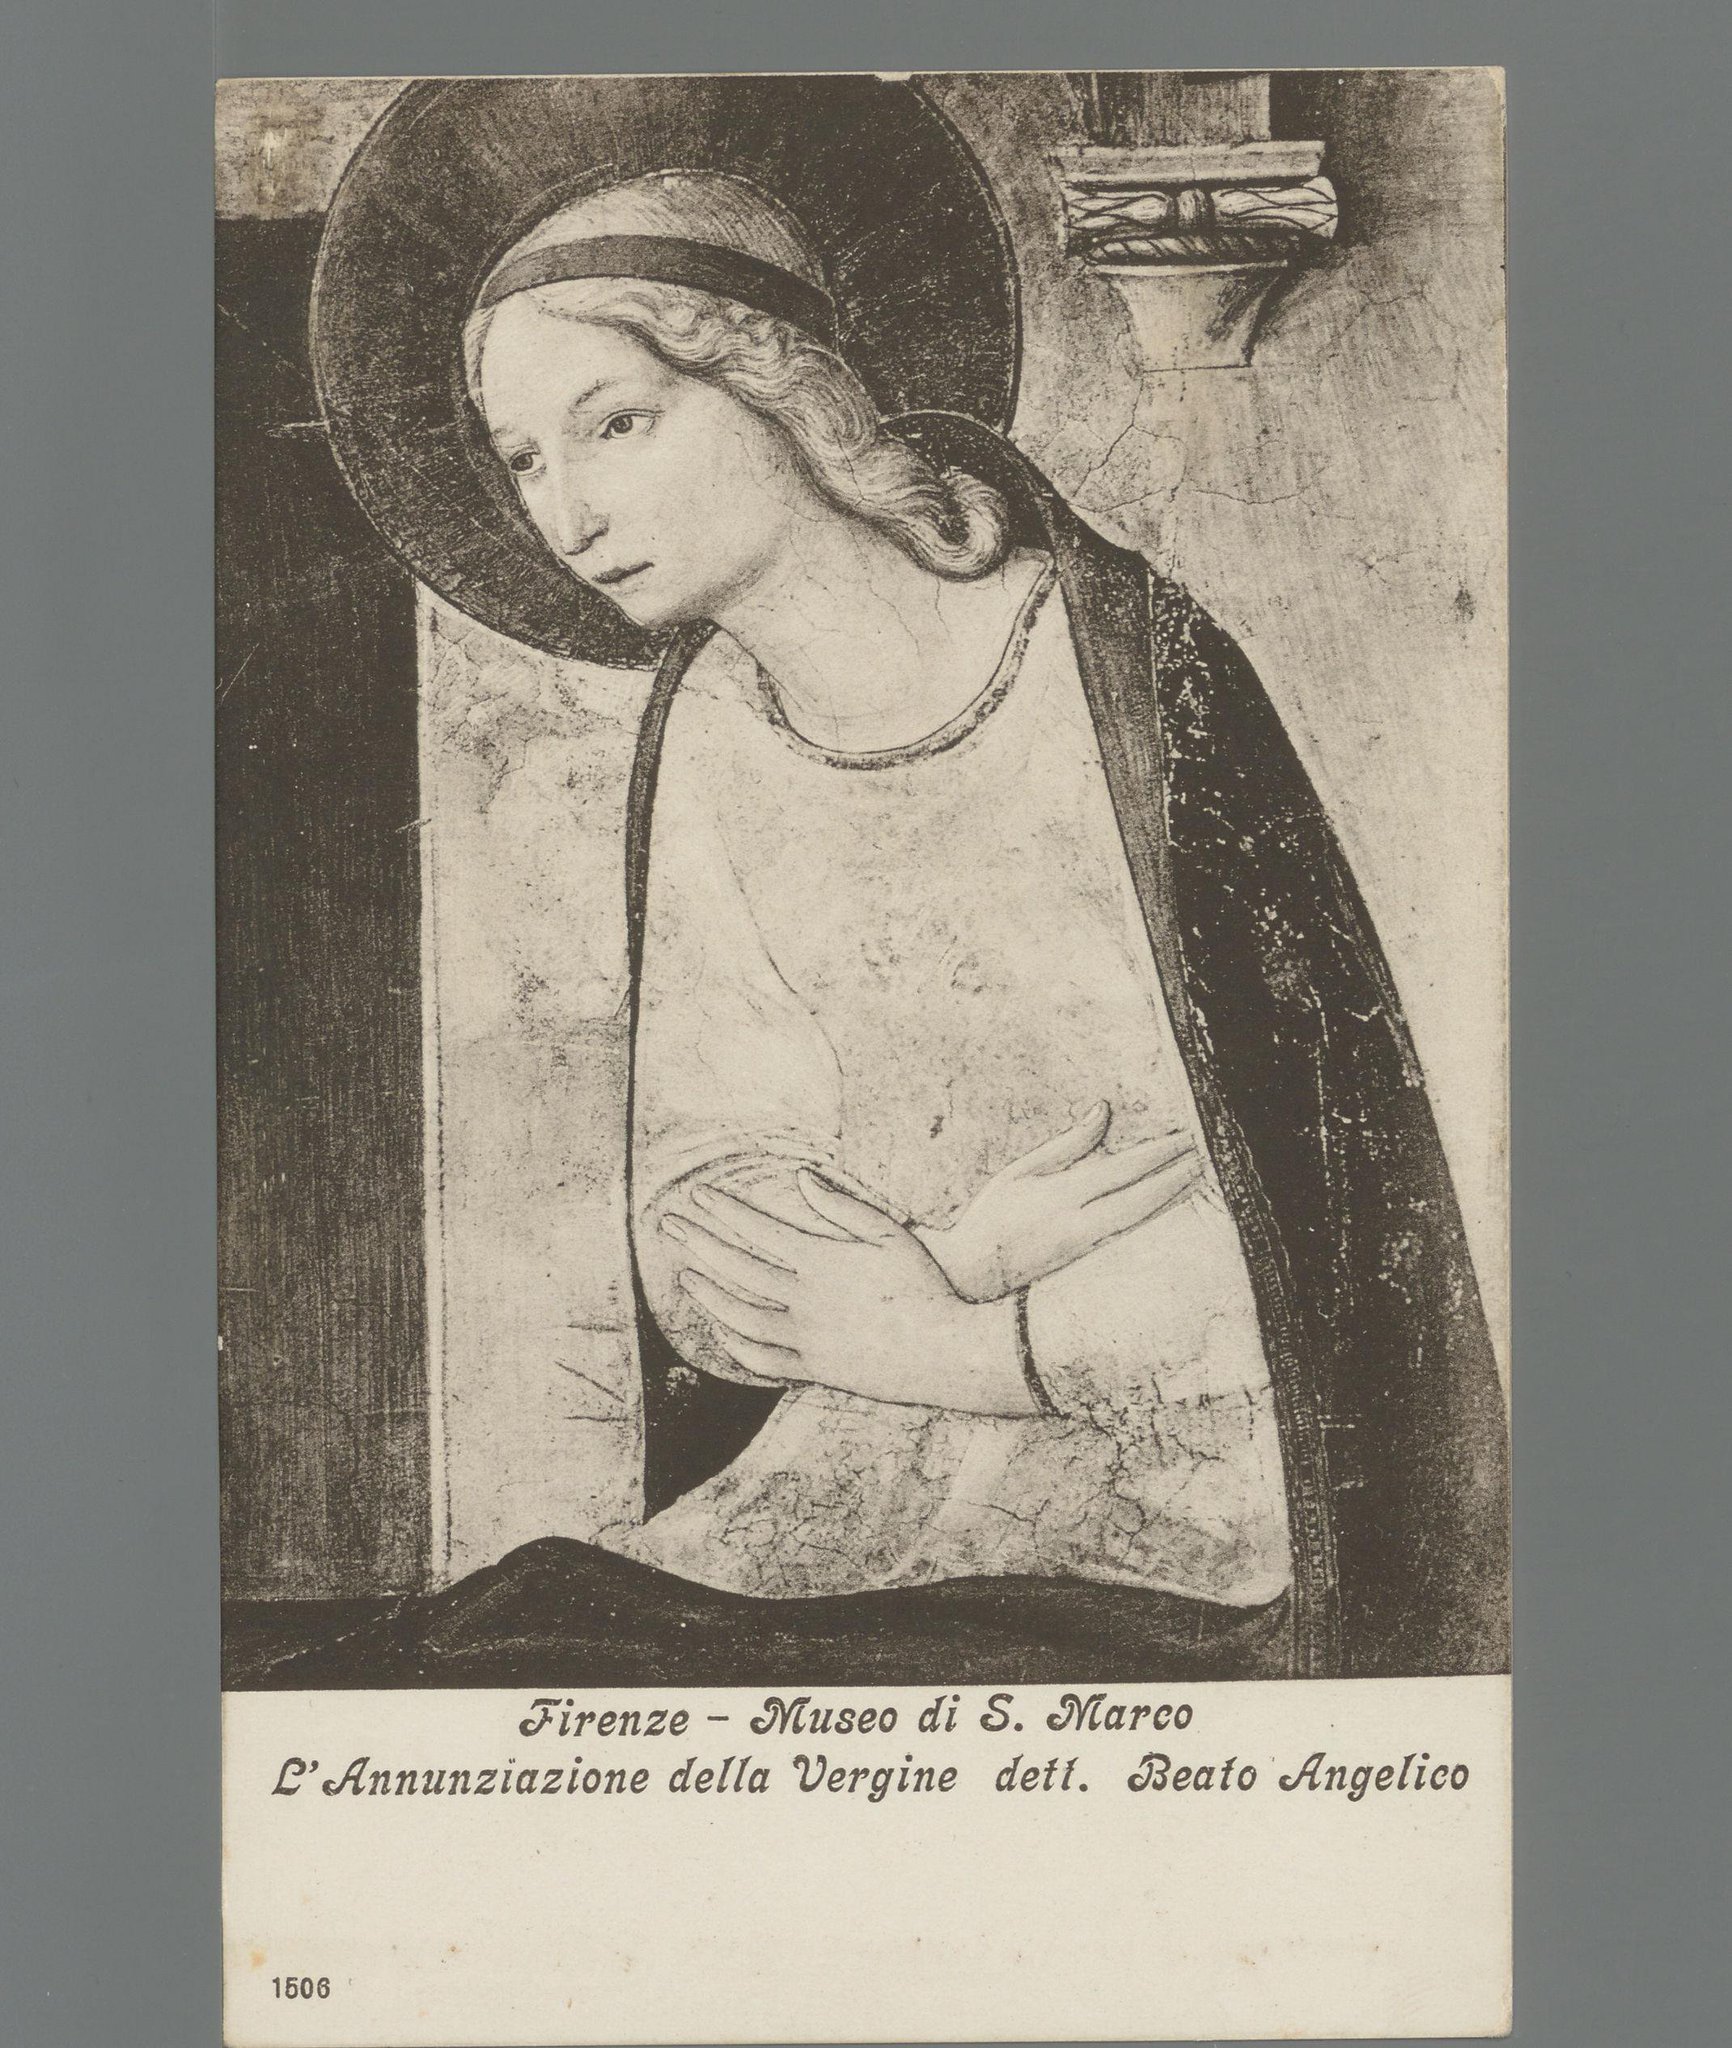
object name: reproduction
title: Firenze - Museo di S. Marco. L'Annunziazione della Vergine dett. Beato Angelico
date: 1906-1930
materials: cardboard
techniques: photograph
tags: permanent exhibition, museum, picture, painting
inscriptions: monogram, collector's mark: ‘AFE v S’